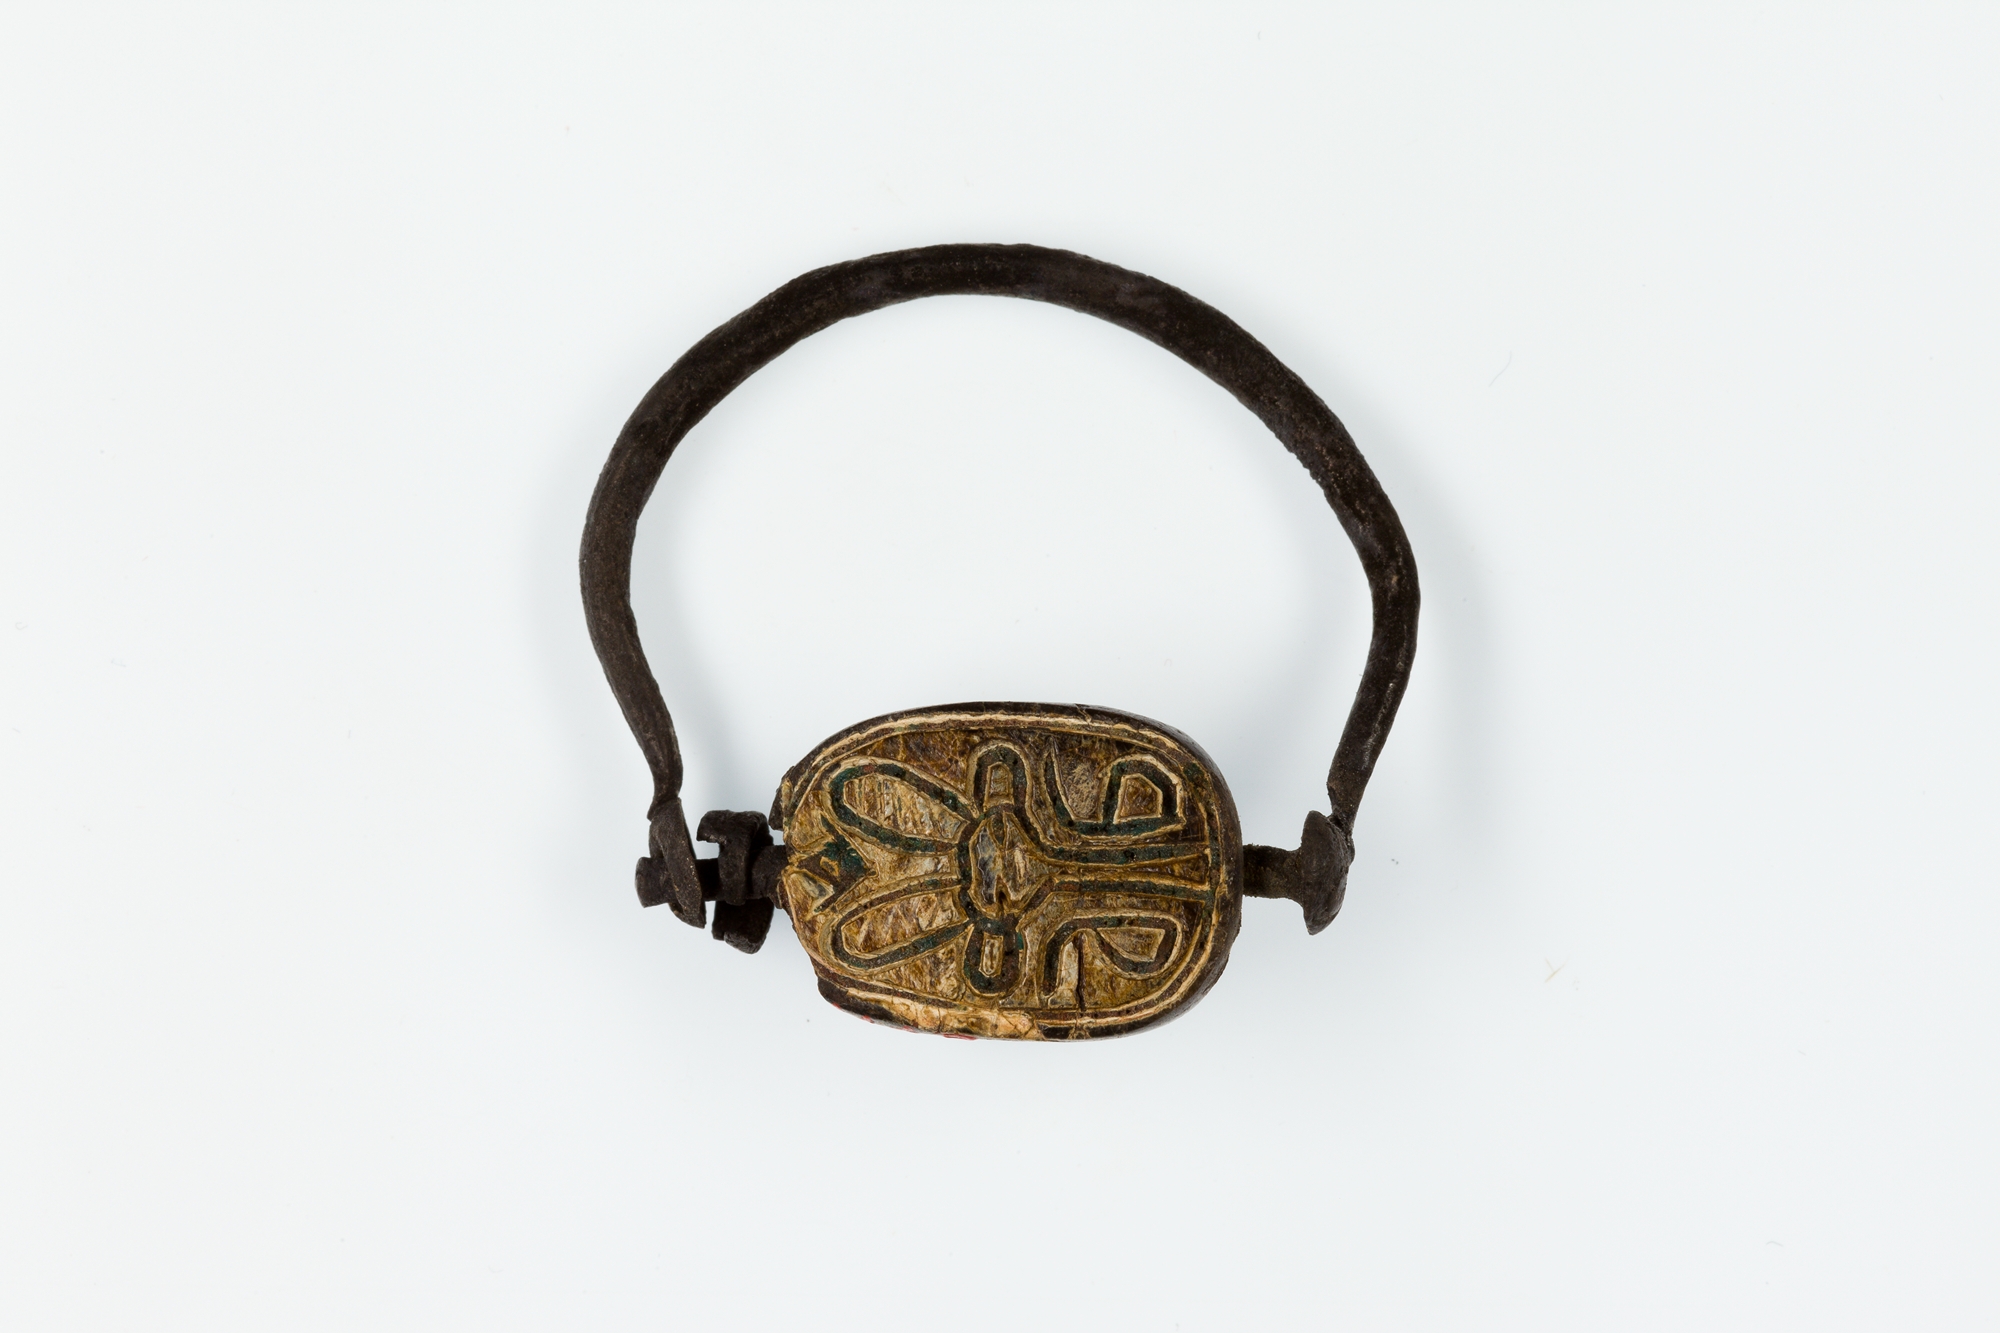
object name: ring, scarab, geometric pattern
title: Scarab Finger Ring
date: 1786-1482 BCE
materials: silver, stone, metal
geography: egypt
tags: scarabs